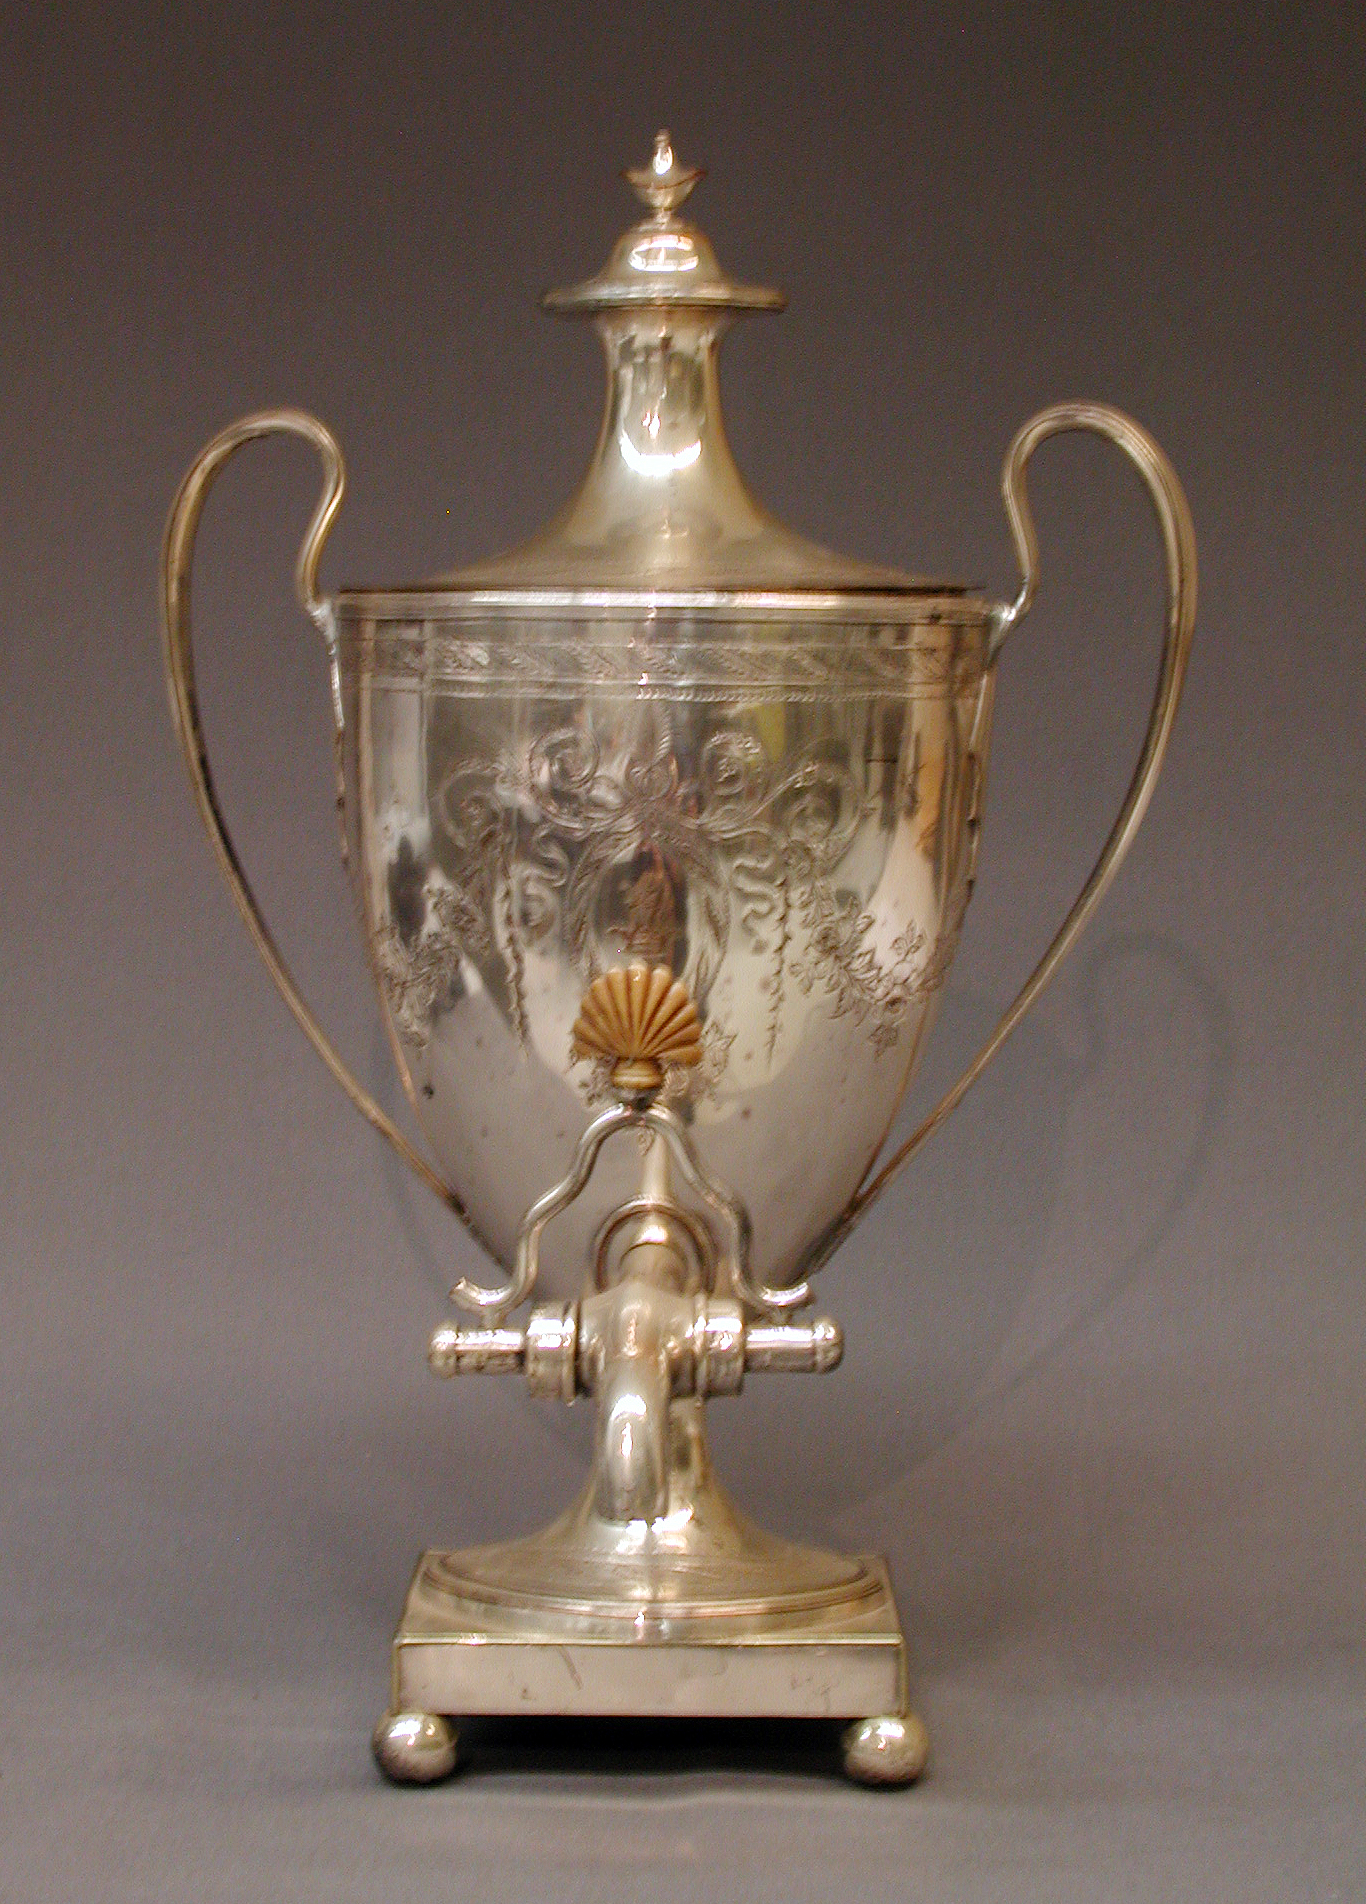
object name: tea urn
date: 1785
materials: metal